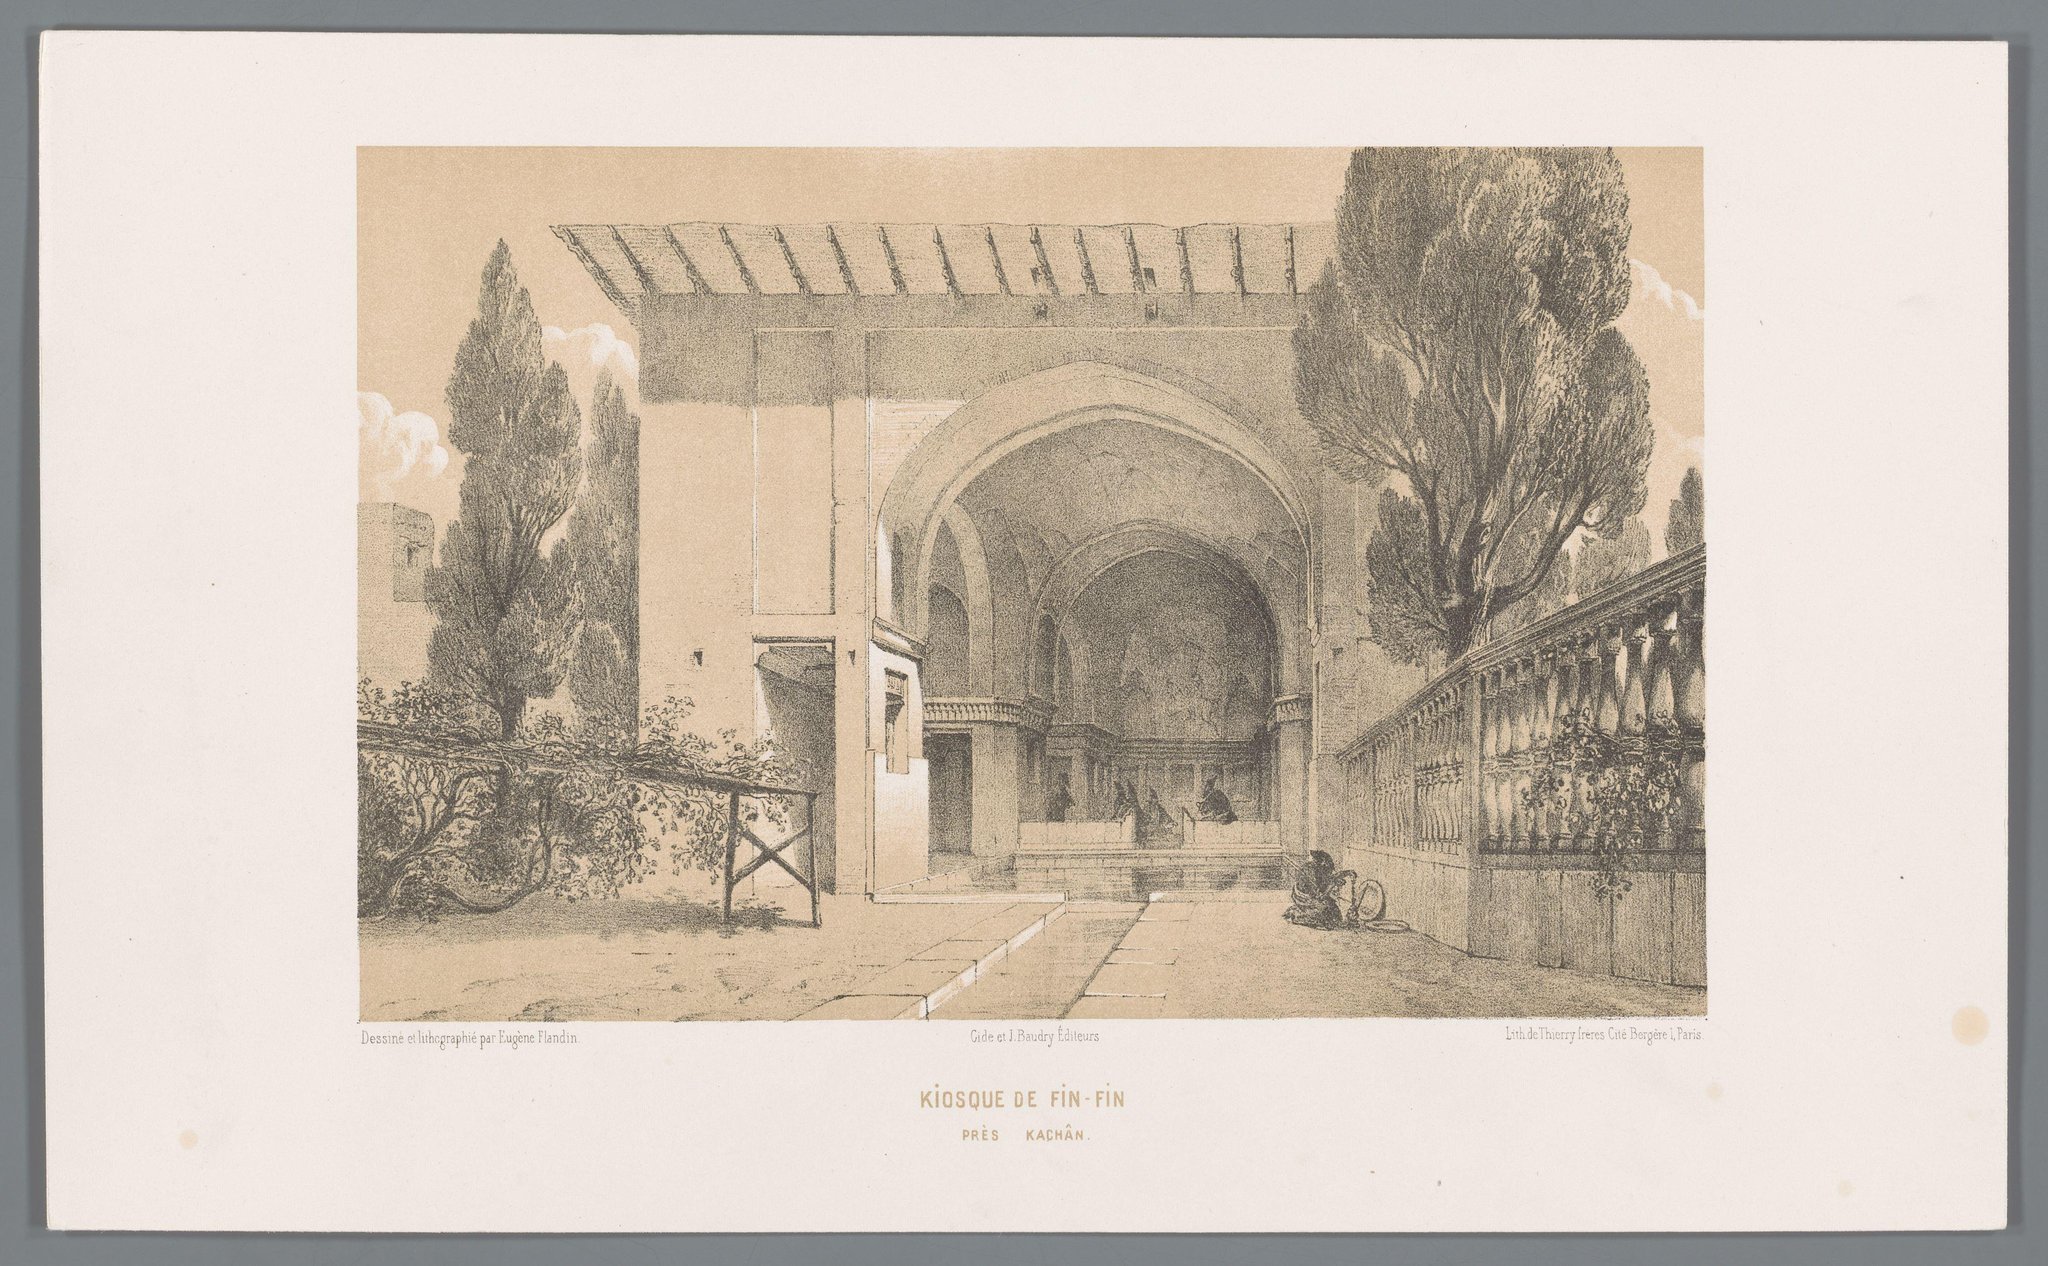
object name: book illustration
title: Kiosk van Fin Garden in Kashan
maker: eugène flandin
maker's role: painter, print maker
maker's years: 1809-1889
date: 1843-1854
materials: paper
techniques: tone lithography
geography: paris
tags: lay-out of garden, water-works in garden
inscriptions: collector's mark: Lugt 2228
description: Bagh-e Fin, zoals de tuin ook bekend is, is een historische Perzische tuin in Kashan, Iran. Uit: Coste, Pascal-Xavier en Eugène Napoléon Flandin. Voyage en Perse de mm. Eugène Flandin, peintre, et Pascal Coste, architecte (...). 8 dln. Parijs: Gide et Jules Baudry, 1843-1854.